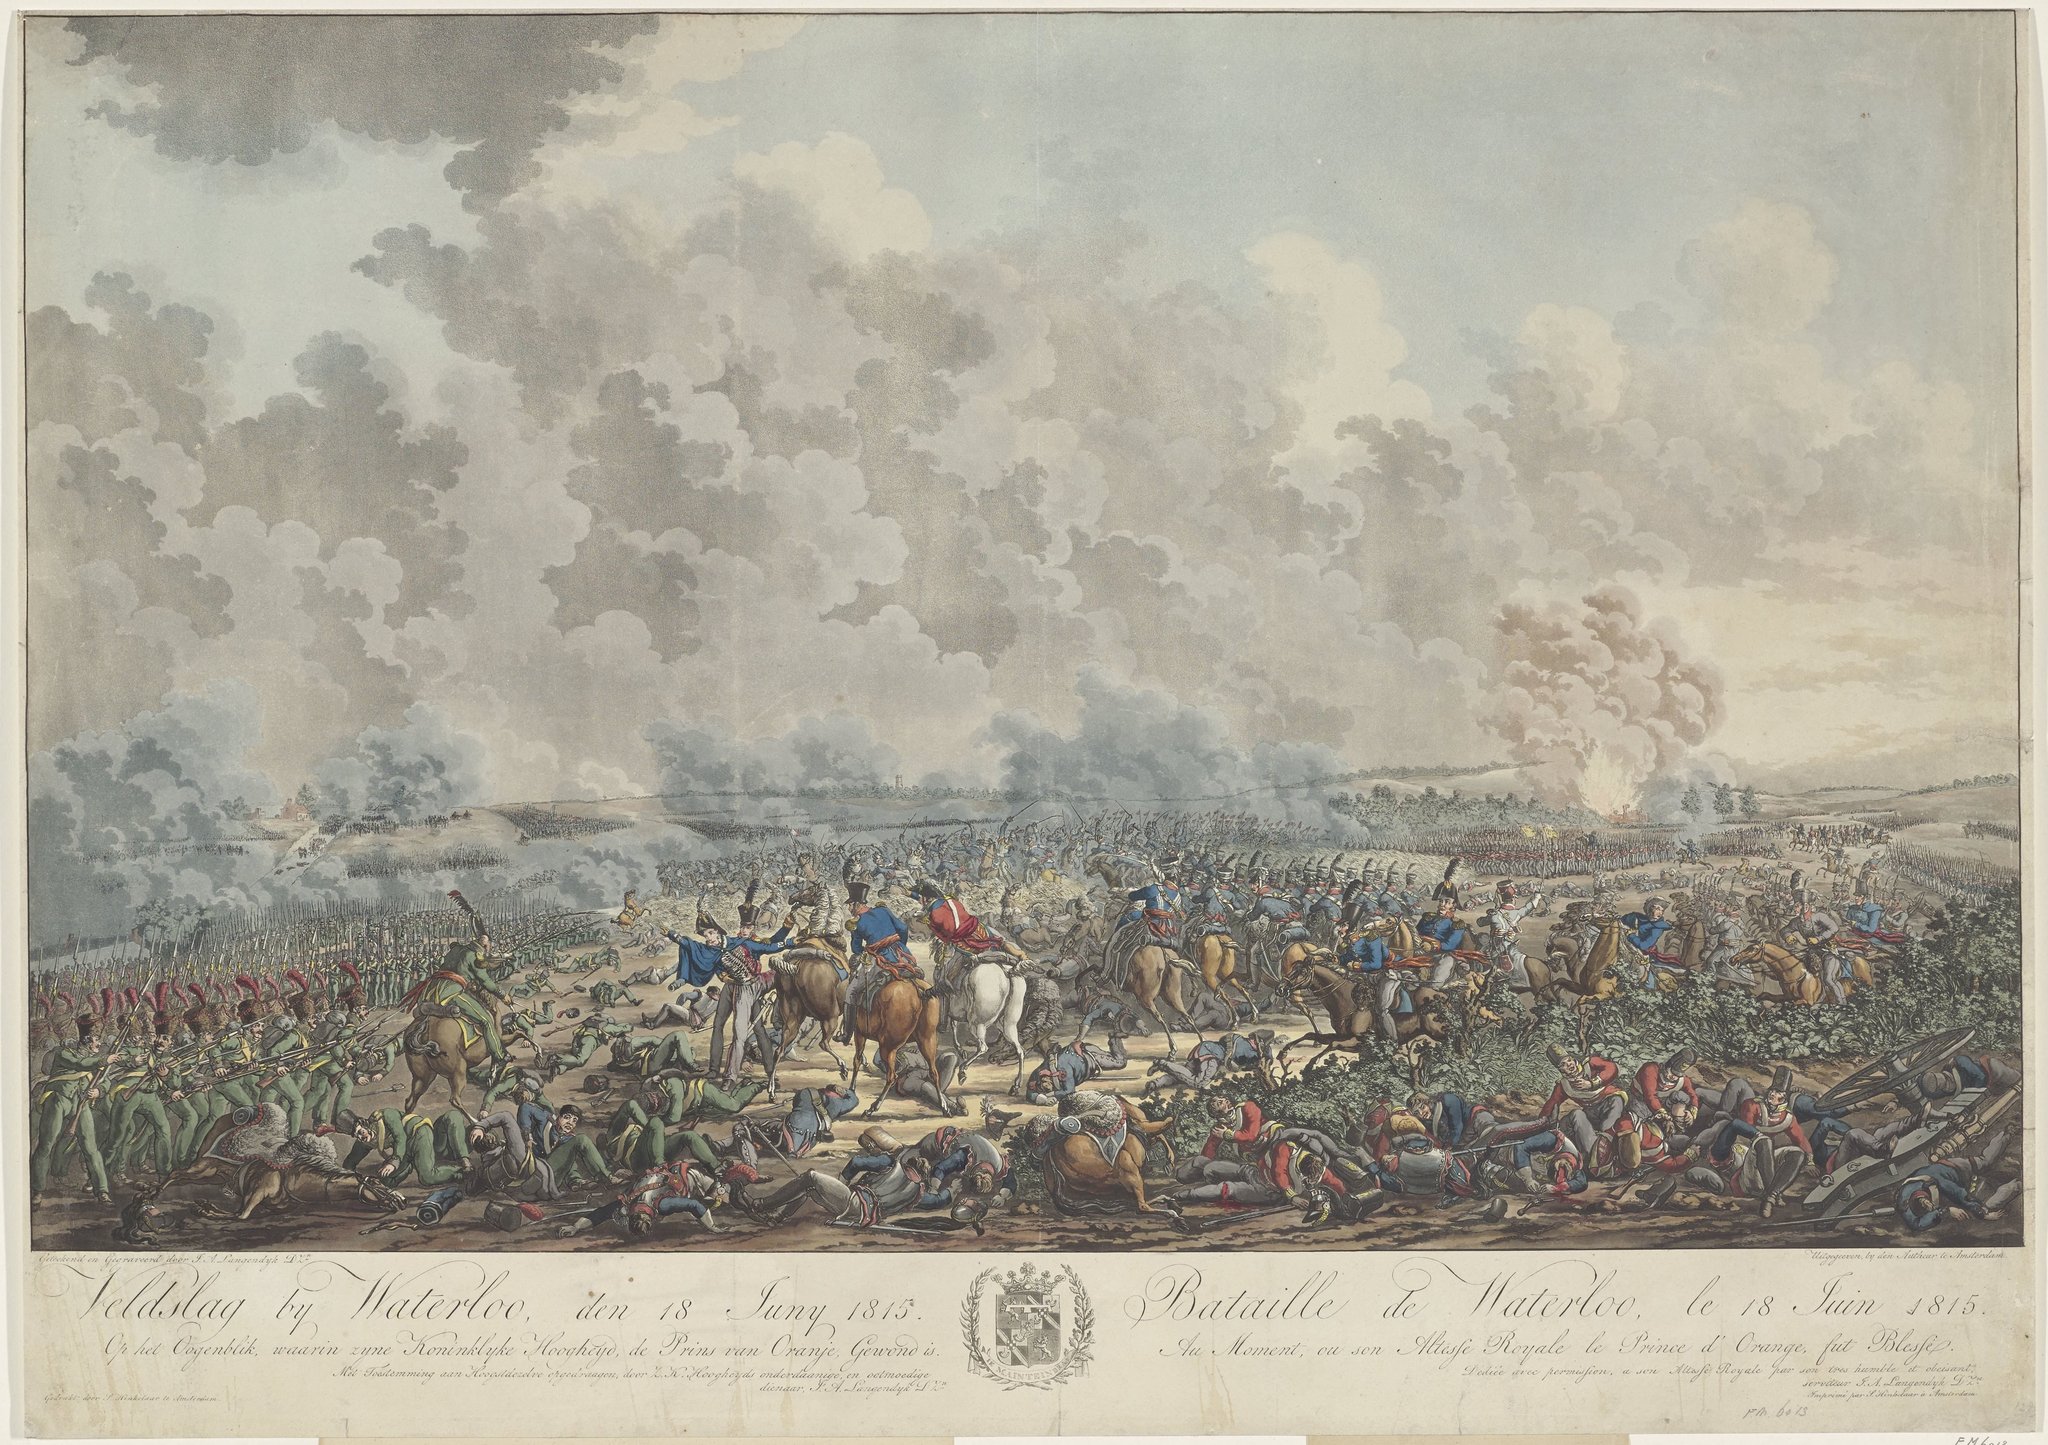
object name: print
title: Veldslag bij Waterloo, den 18 Juny 1815. Op het Oogenblik, waarin zyne Koninklyke Hoogheyd. de Prins van Oranje, Gewond is / Bataille de Waterloo, le 18 Juin 1915 (...)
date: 1815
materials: paper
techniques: etching, hand coloring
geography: amsterdam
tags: the hague, william ii of the netherlands, battle (+ land forces), waterloo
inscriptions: collector's mark: Lugt 2228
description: De slag bij Waterloo, 18 juni 1815. Weids gezicht van het slagveld, met links van het midden het moment dat de prins van Oranje gewond raakt. Links van de prins op de achtergrond wordt ook zijn paard ('Vexy') door een kogel getroffen. Links oprukkende Brunswijkers. Rechts in de verte het brandende kasteel Hougoumont, oprukkende Engelse infanterie en de hertog van Wellington te paard. Onderaan het wapen van de prins van Oranje tussen de Nederlandse en Franse titels. Bij de prent behoort een aparte sleutel en een gedrukte verklaring.